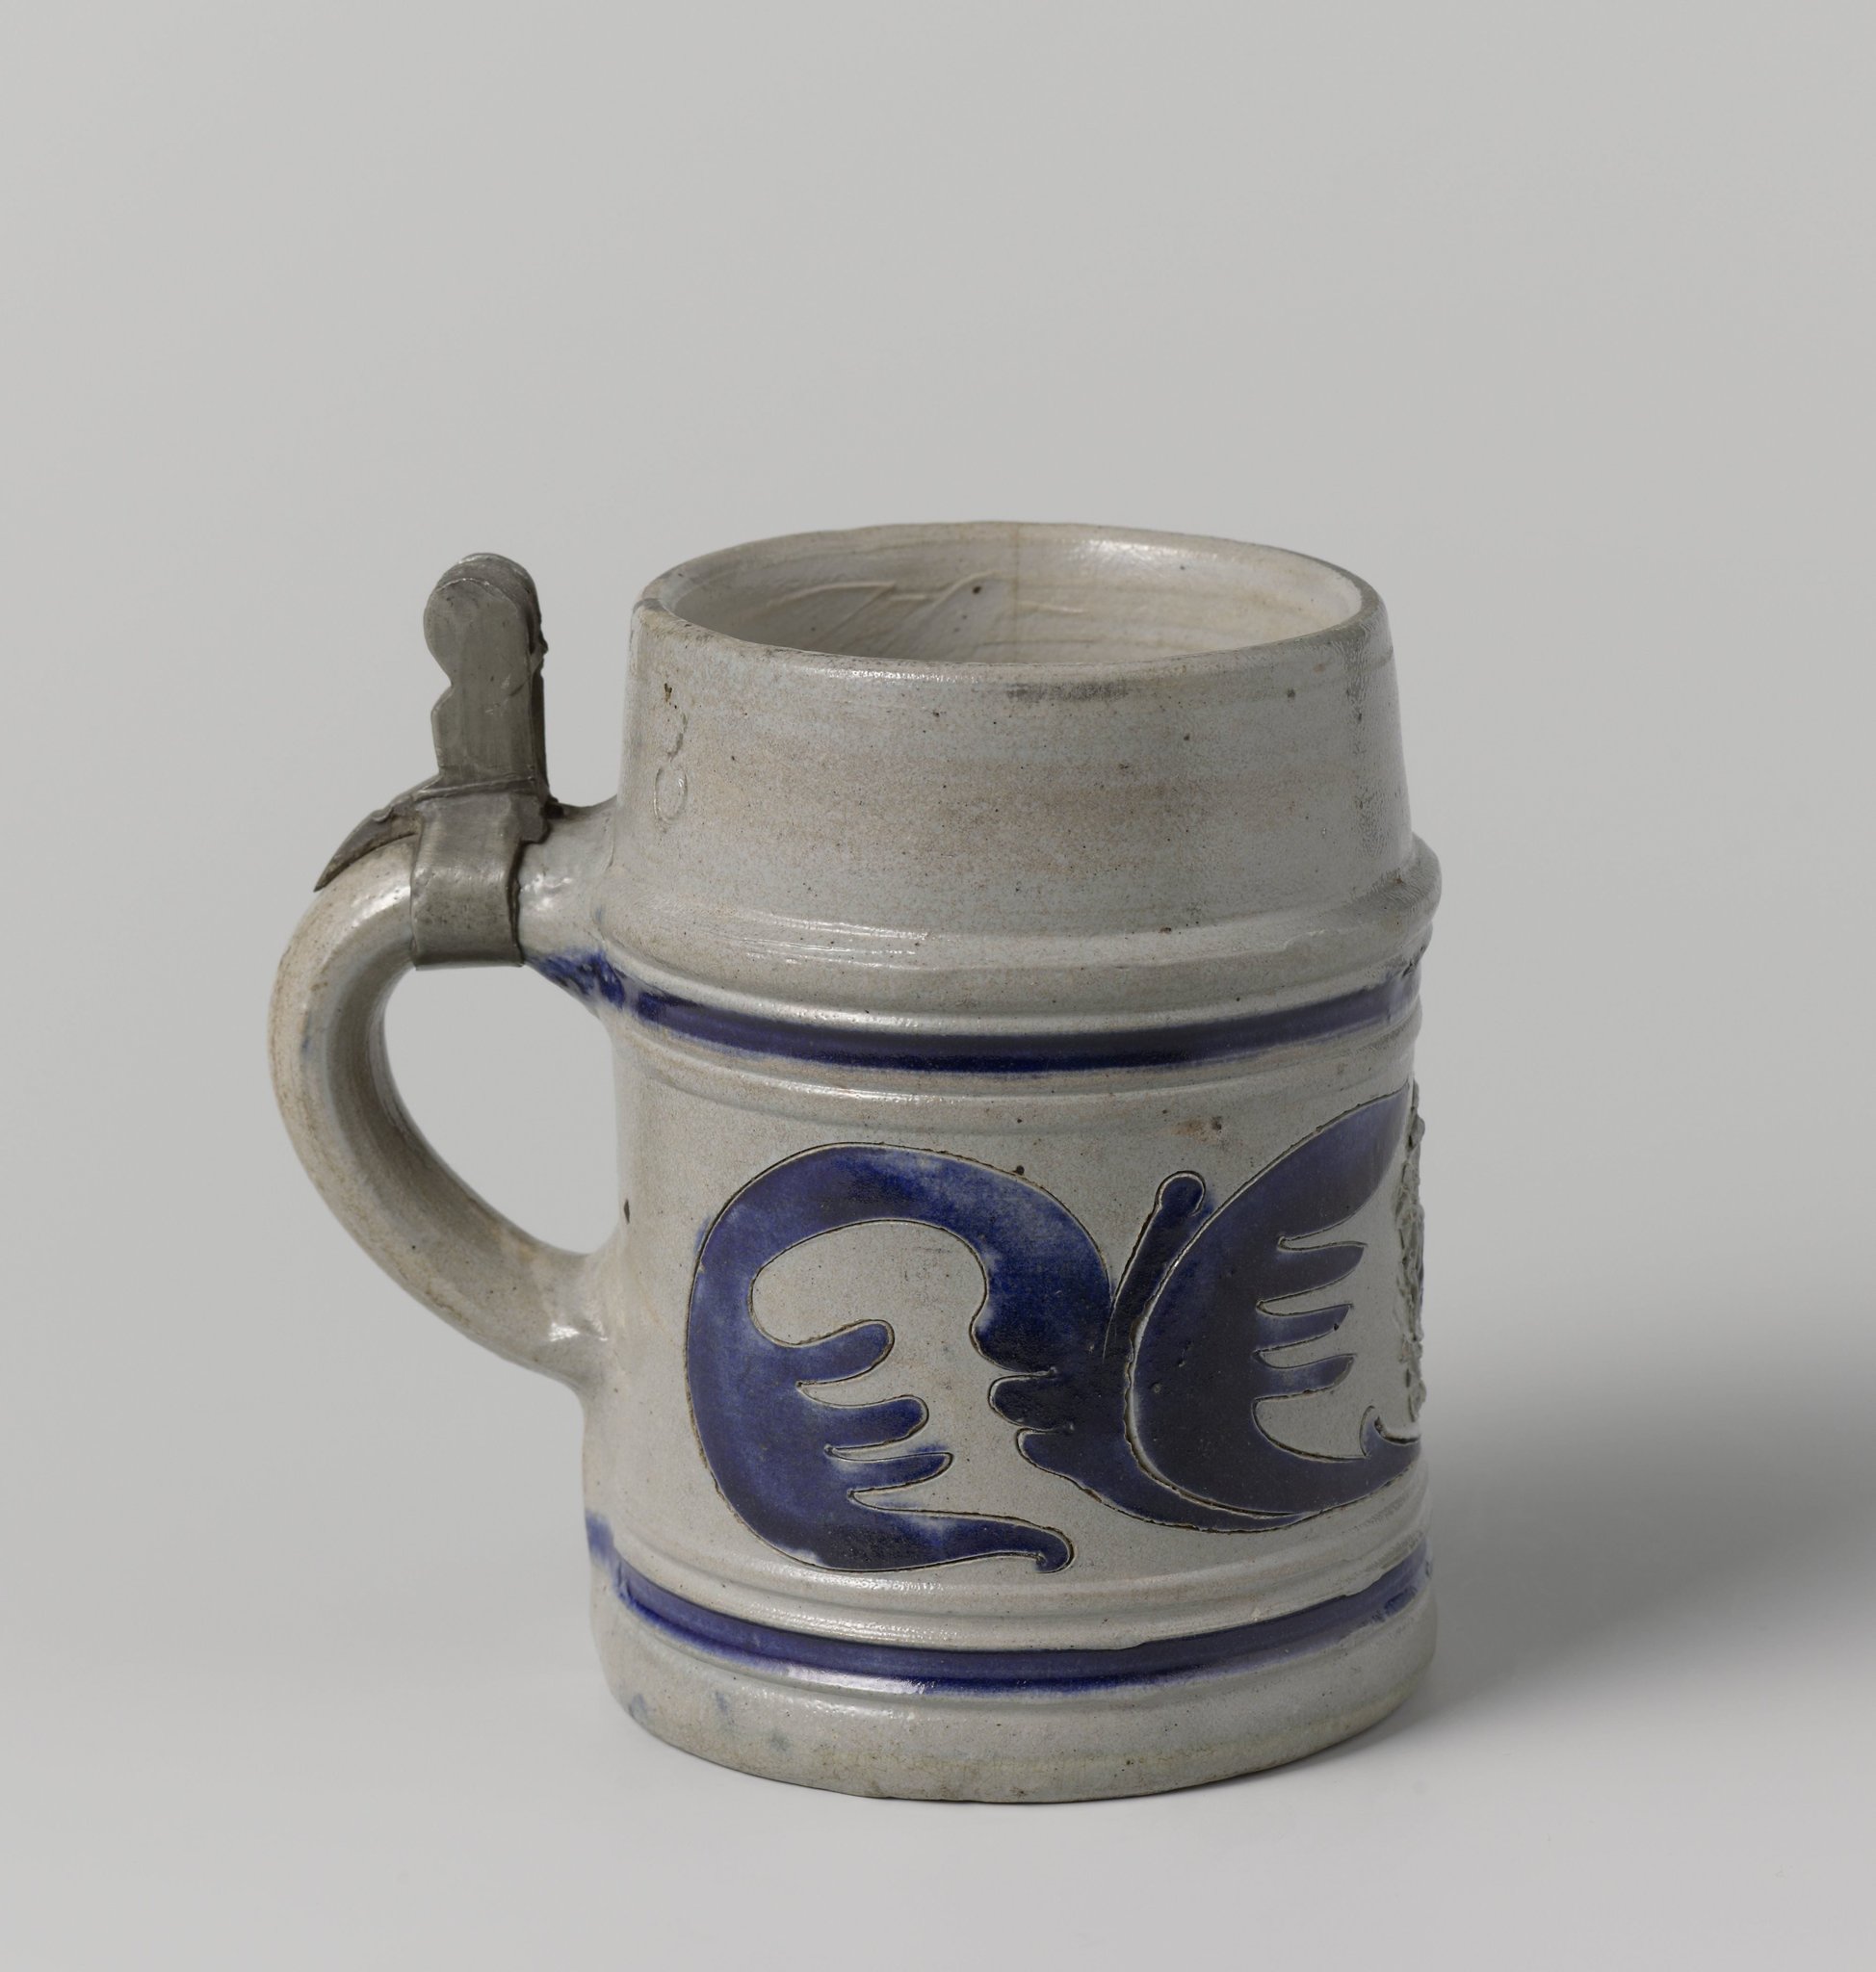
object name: cup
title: Tankard with a monogram and stylized foliate scrolls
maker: Anonymous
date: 1710-1730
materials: cobalt, glaze, stoneware, tin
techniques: firing, forming, relief, turning, vitrification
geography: westerwald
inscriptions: inscription: ‘G R’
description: Cilindrische bierpul van steengoed met een C-vormig oor. Gedeeltelijk bedekt met kobaltblauw. Tussen twee profielen met een blauwe horizontale lijn is in reliëf een gedrukt en opgelegd monogram aangebracht met de letters 'G R' (George Rex, ofwel Koning George van Engeland) in een medaillon met bladeren. Om het medaillon ingegrifte, gestileerde bladranken. Aan het oor het scharnier voor een tinnen montuur; de deksel ontbreekt. Westerwald.